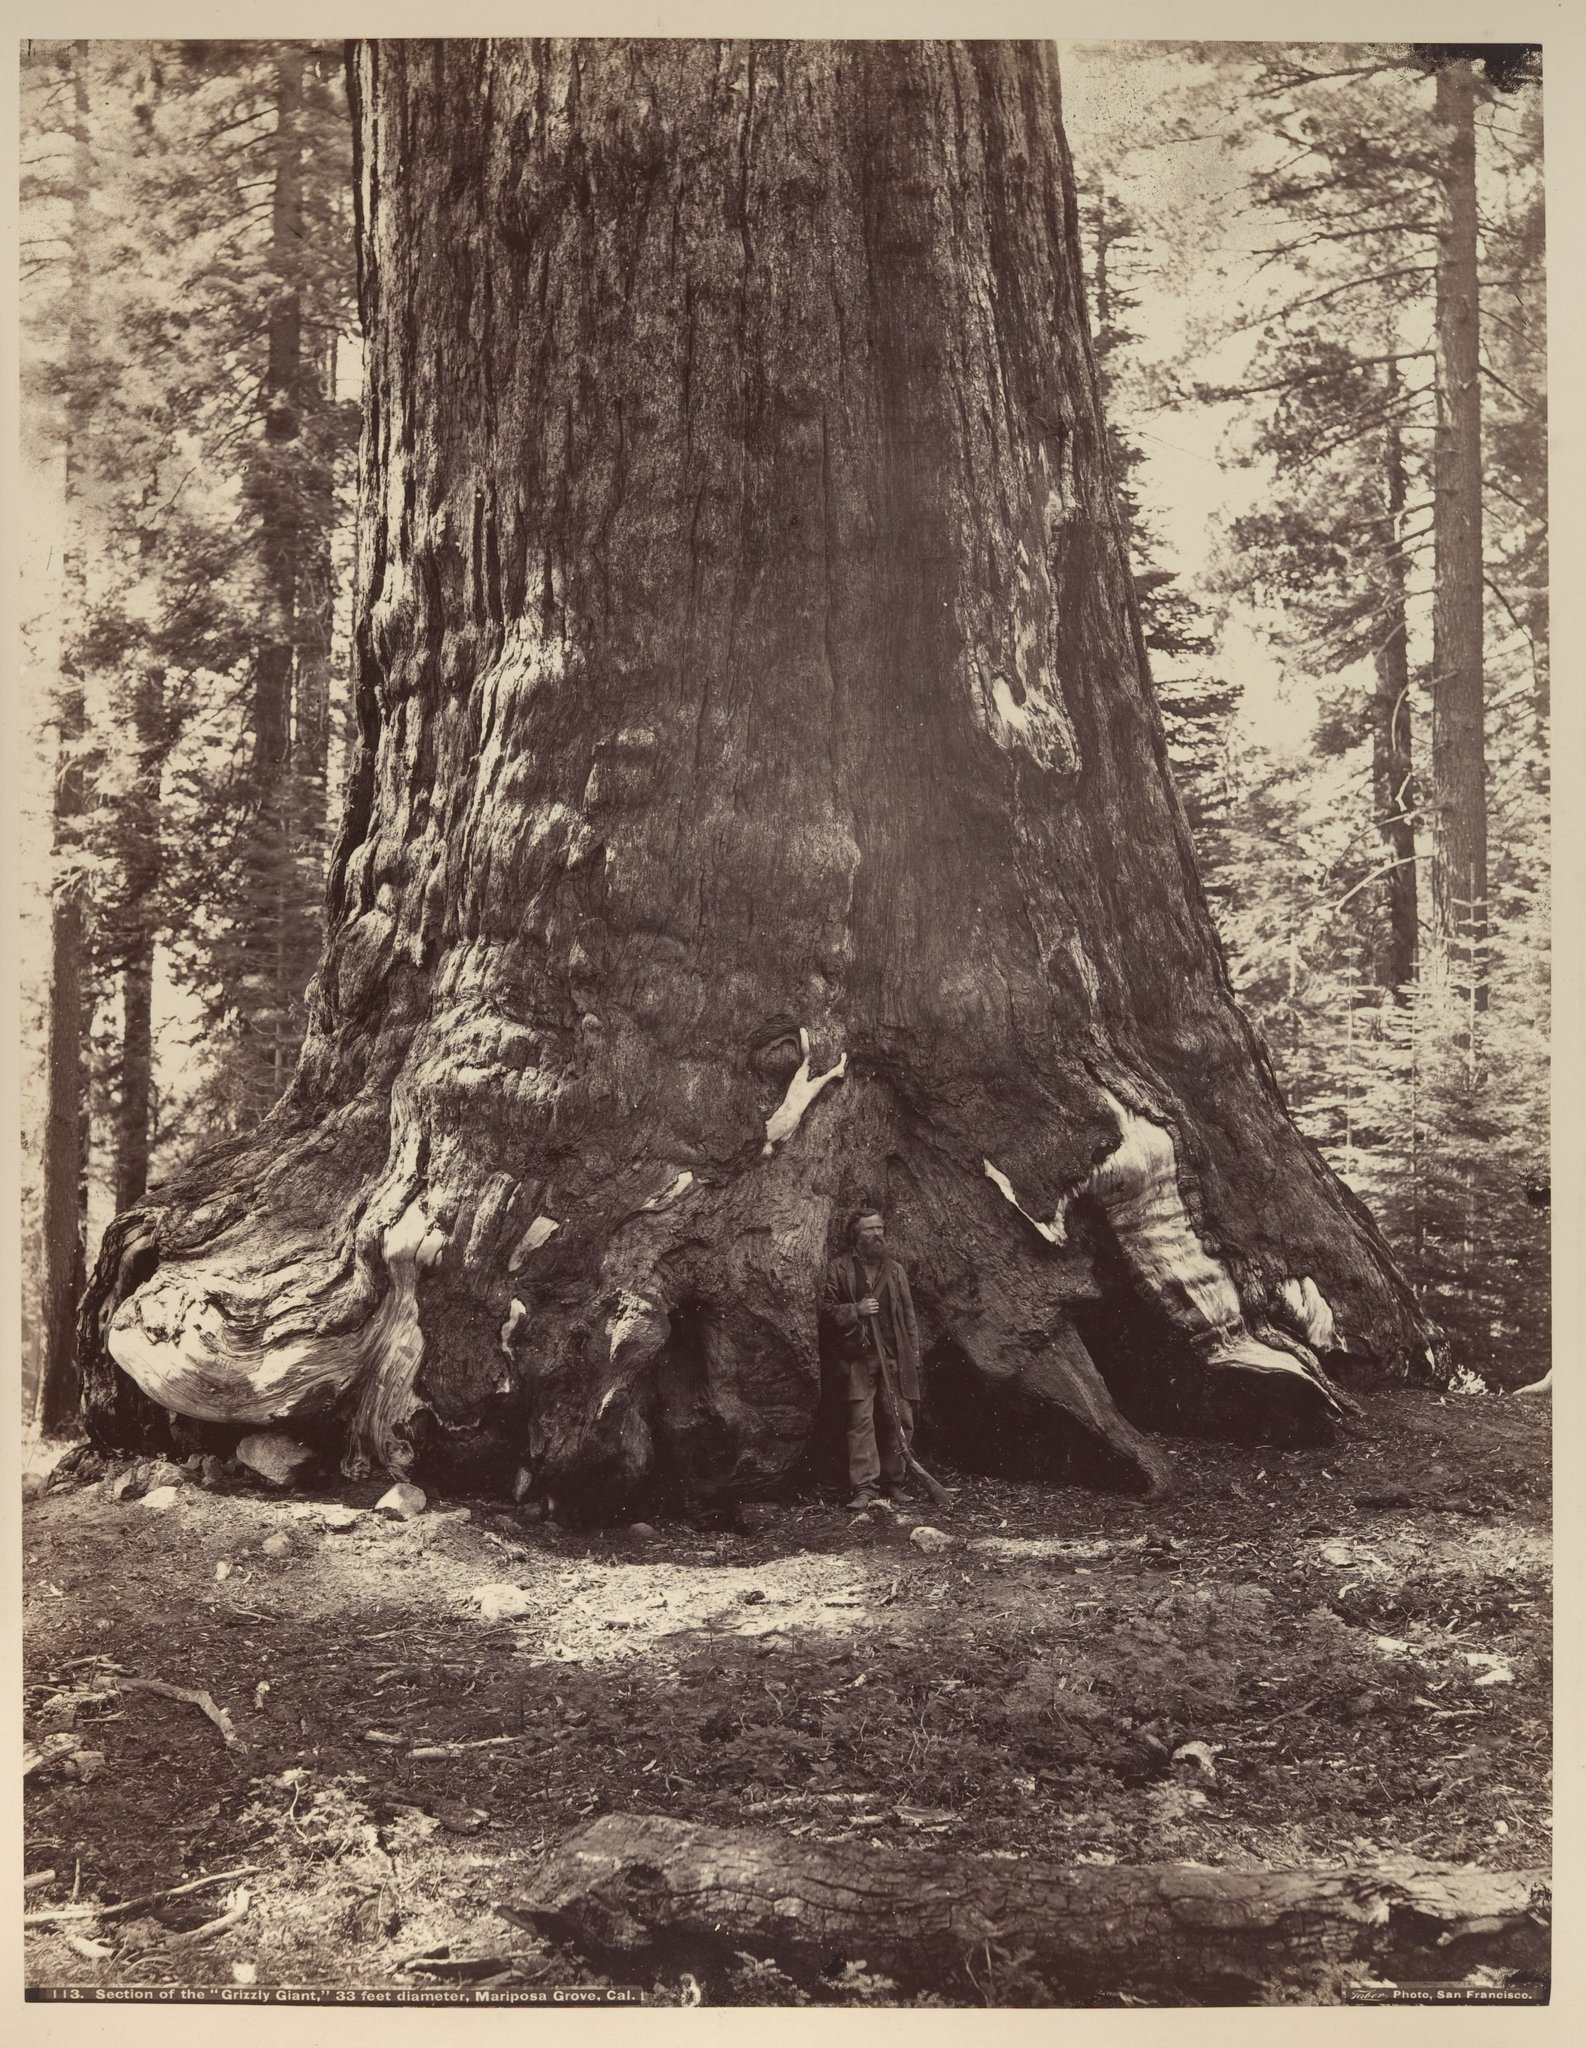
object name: photograph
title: Section of the Grizzly Giant with Galen Clark, Mariposa Grove, Yosemite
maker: carleton e. watkins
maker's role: artist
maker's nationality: american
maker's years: 1829-1916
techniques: albumen silver print, glass negative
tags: men,trees